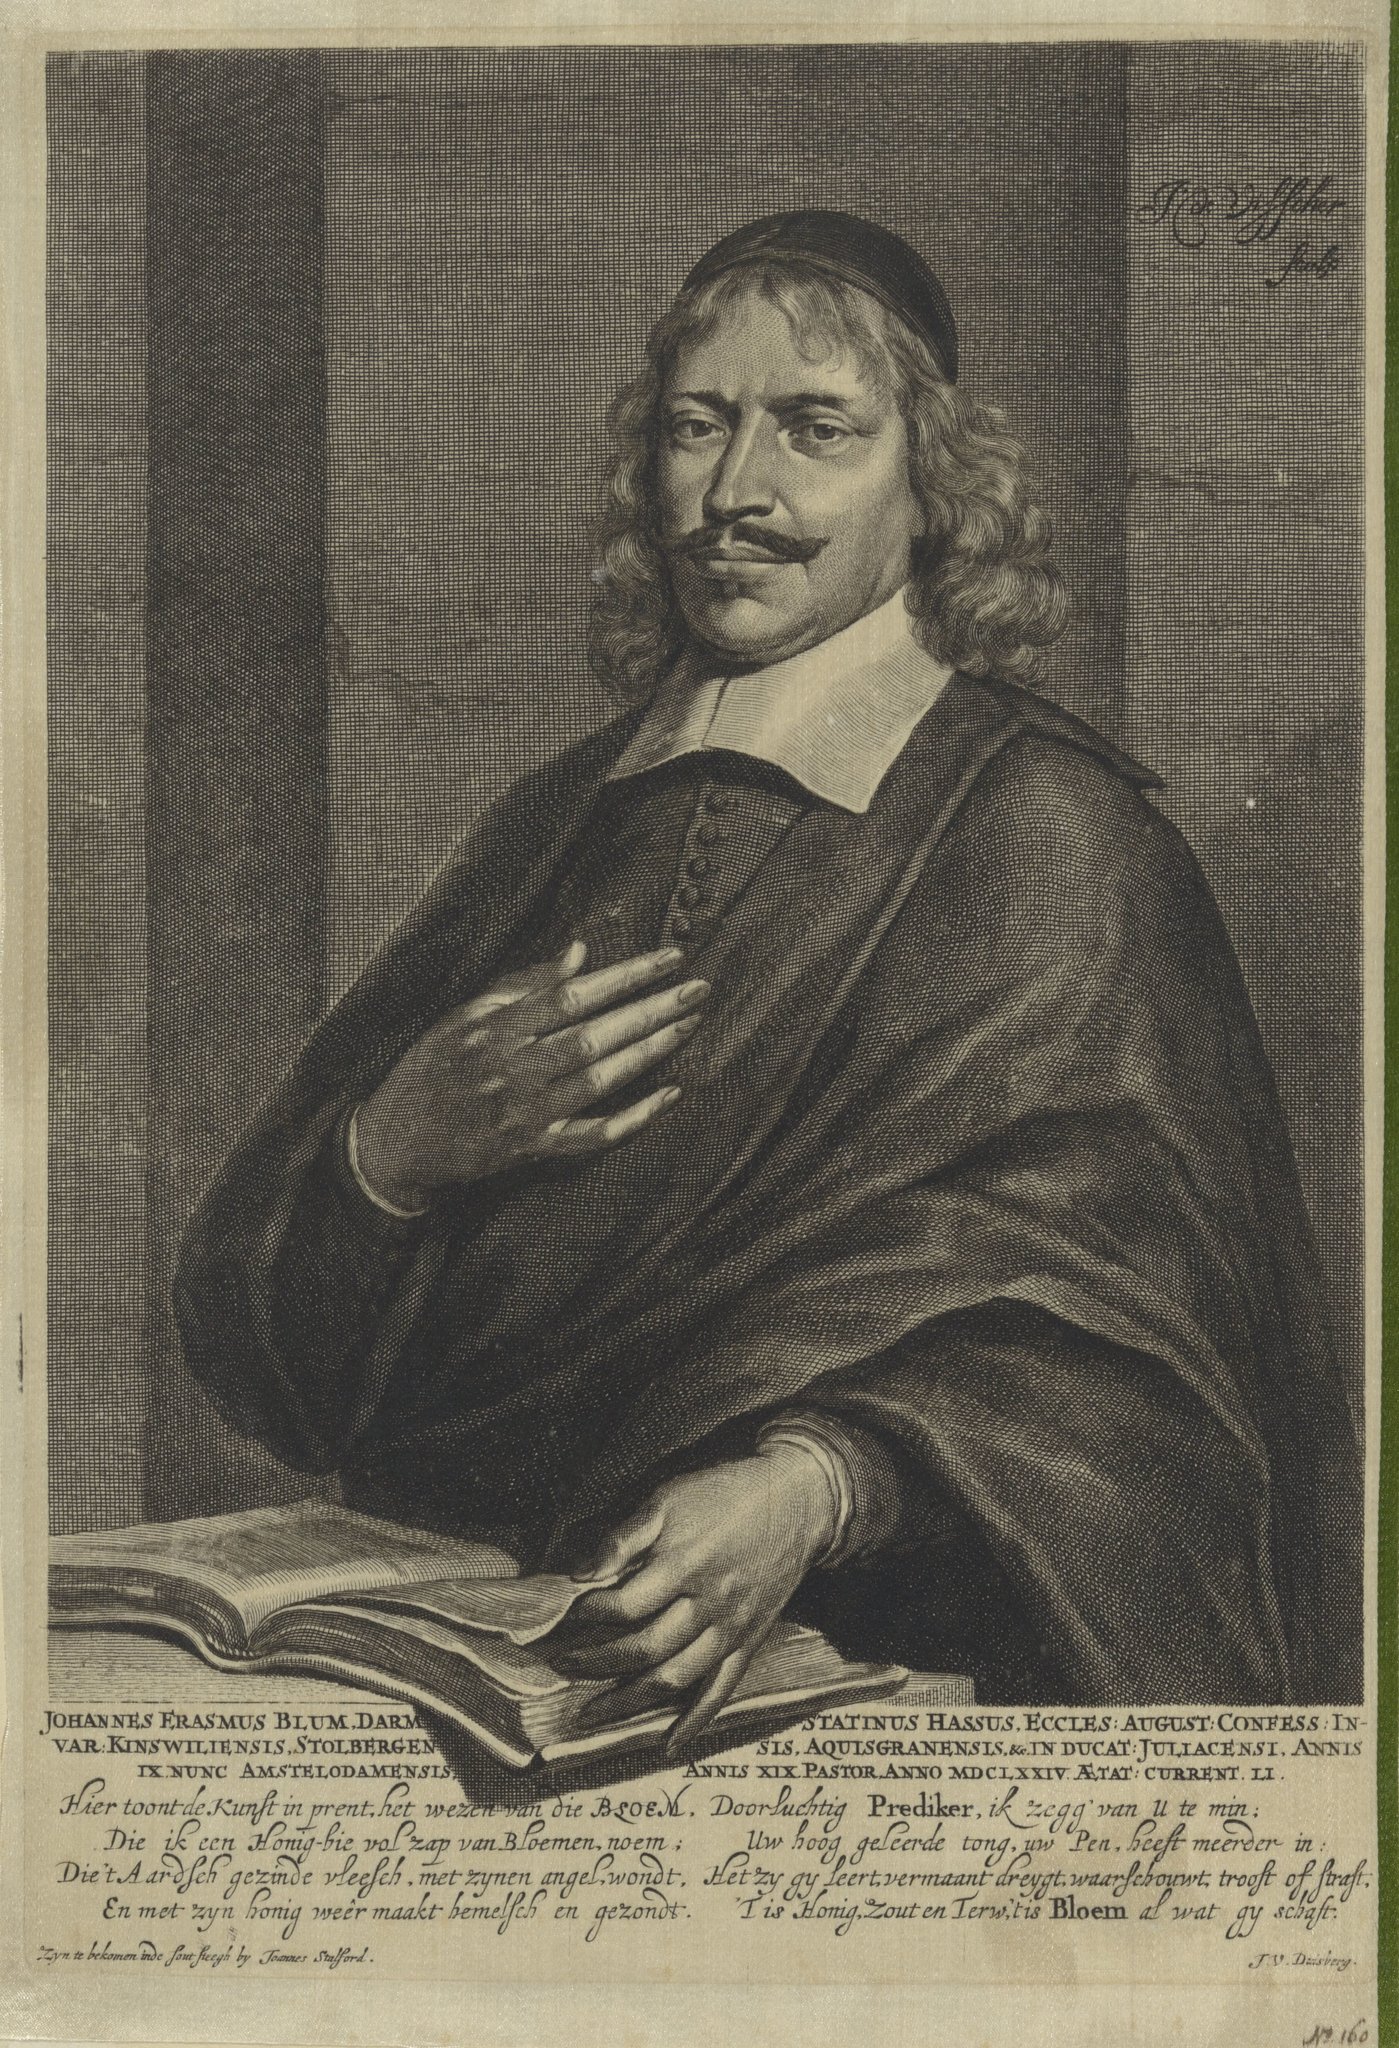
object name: print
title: Portret van Johannes Erasmus Blum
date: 1674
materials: silk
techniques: engraving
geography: amsterdam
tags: book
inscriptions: collector's mark: Lugt 240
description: De predikant Johannes Erasmus Blum houdt zijn rechterhand op de borst en bladert met zijn andere in het boek dat voor hem ligt. In de marge een lofdicht.